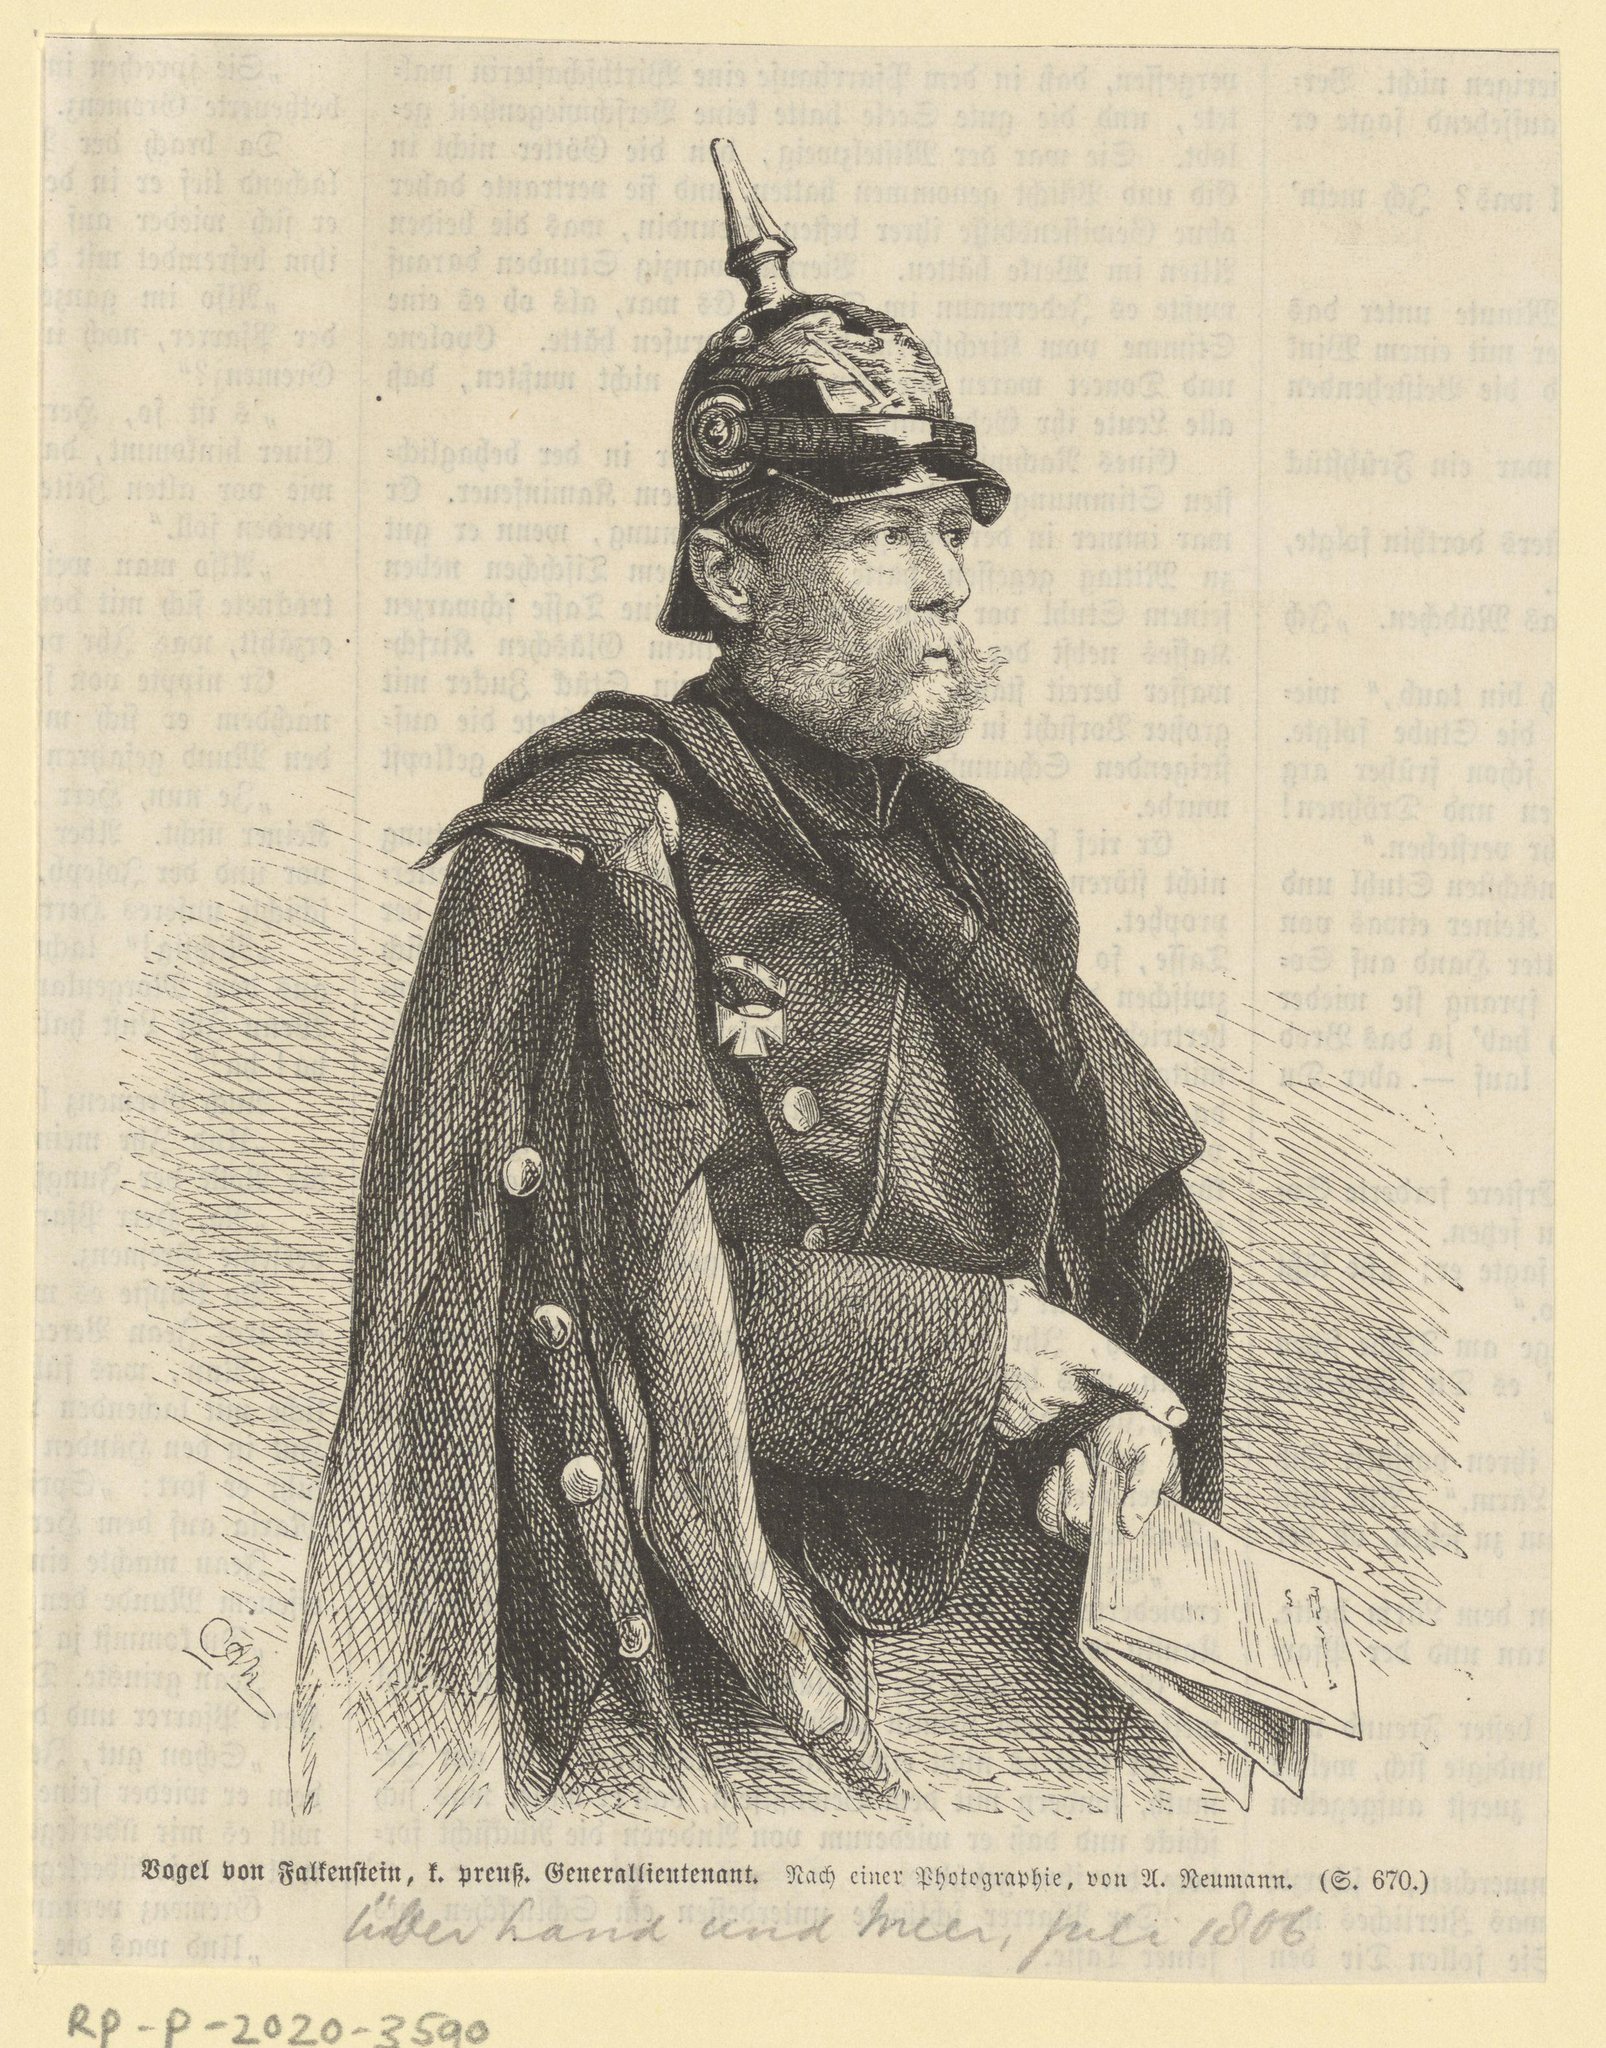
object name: print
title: Portret van Eduard Vogel von Falckenstein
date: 1866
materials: paper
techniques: letterpress printing, engraving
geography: germany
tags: commander-in-chief, general, marshal, historical persons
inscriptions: monogram: ‘CAM [?]’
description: Prent uit: Über Land und Meer. Allgemeine illustrirte Zeitung, juli 1866.